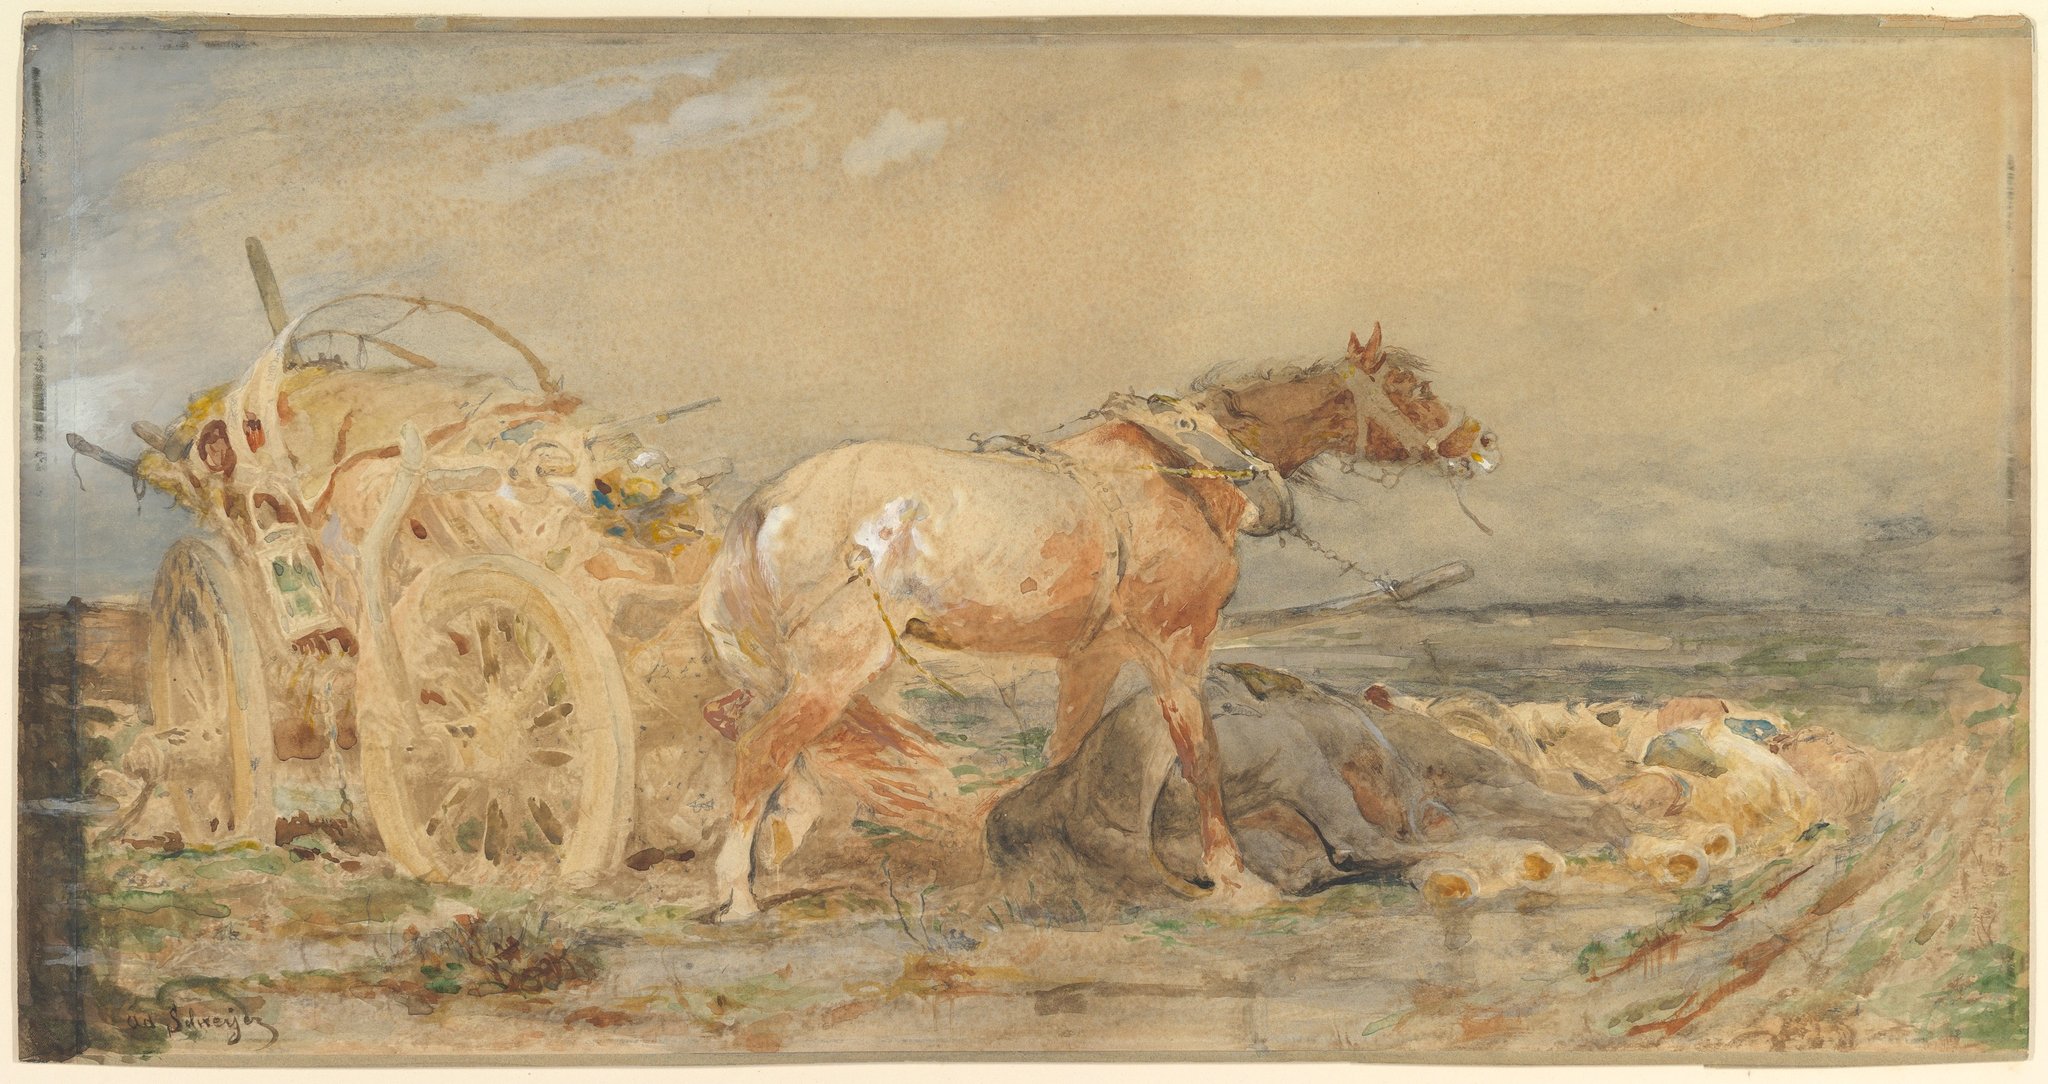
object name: drawing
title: Abandoned: Marshes of the Danube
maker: adolf schreyer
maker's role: artist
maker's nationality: german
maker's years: 1828-1899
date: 1887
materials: gouache, graphite, watercolor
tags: horses,carriages